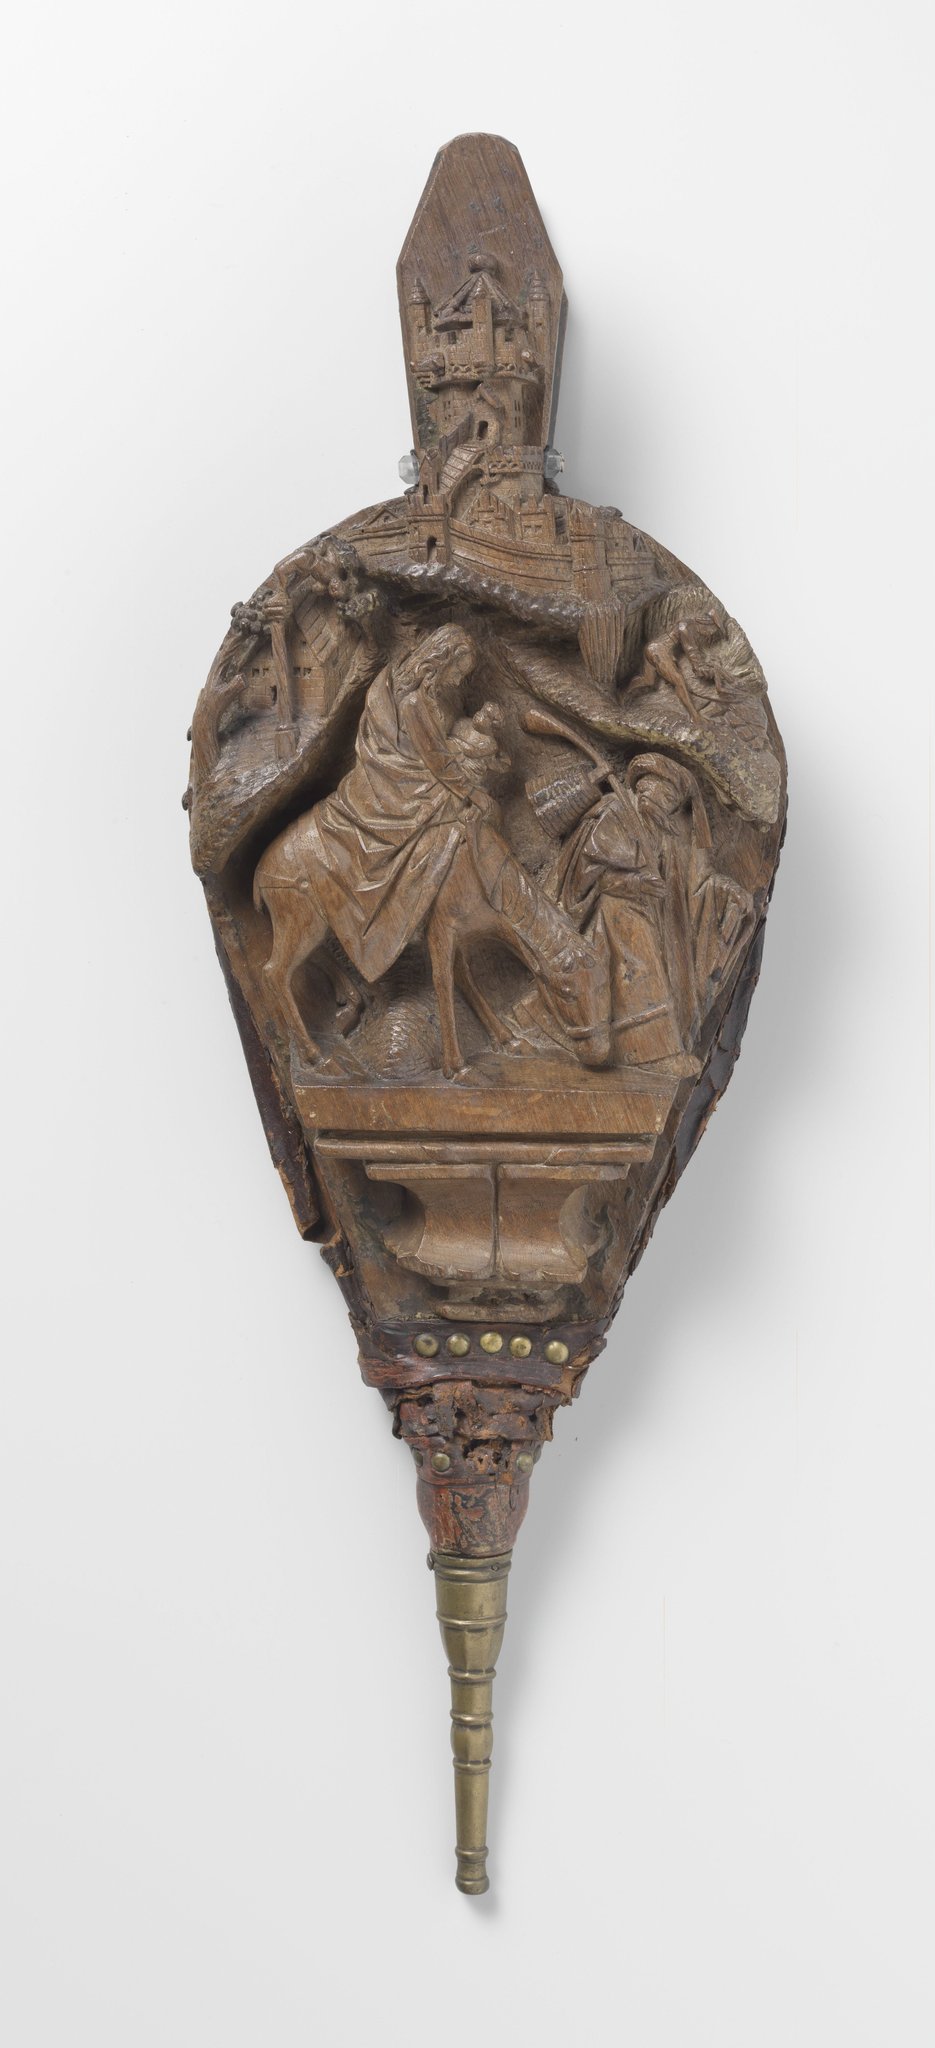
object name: bellow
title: Pair of Bellows with the Flight into Egypt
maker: master of the utrecht stone female head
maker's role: sculptor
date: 1510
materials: brass, leather, wood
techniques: polychromy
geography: utrecht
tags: the flight into egypt: mary, joseph, the child (and sometimes others) on their way; mary usually riding on an ass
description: Master of the Stone Female Head at Utrecht (active c. 1490 - c. 1530). Pair of bellows with the Flight into Egypt. Oak with traces of polychromy Utrecht, c. 1510.